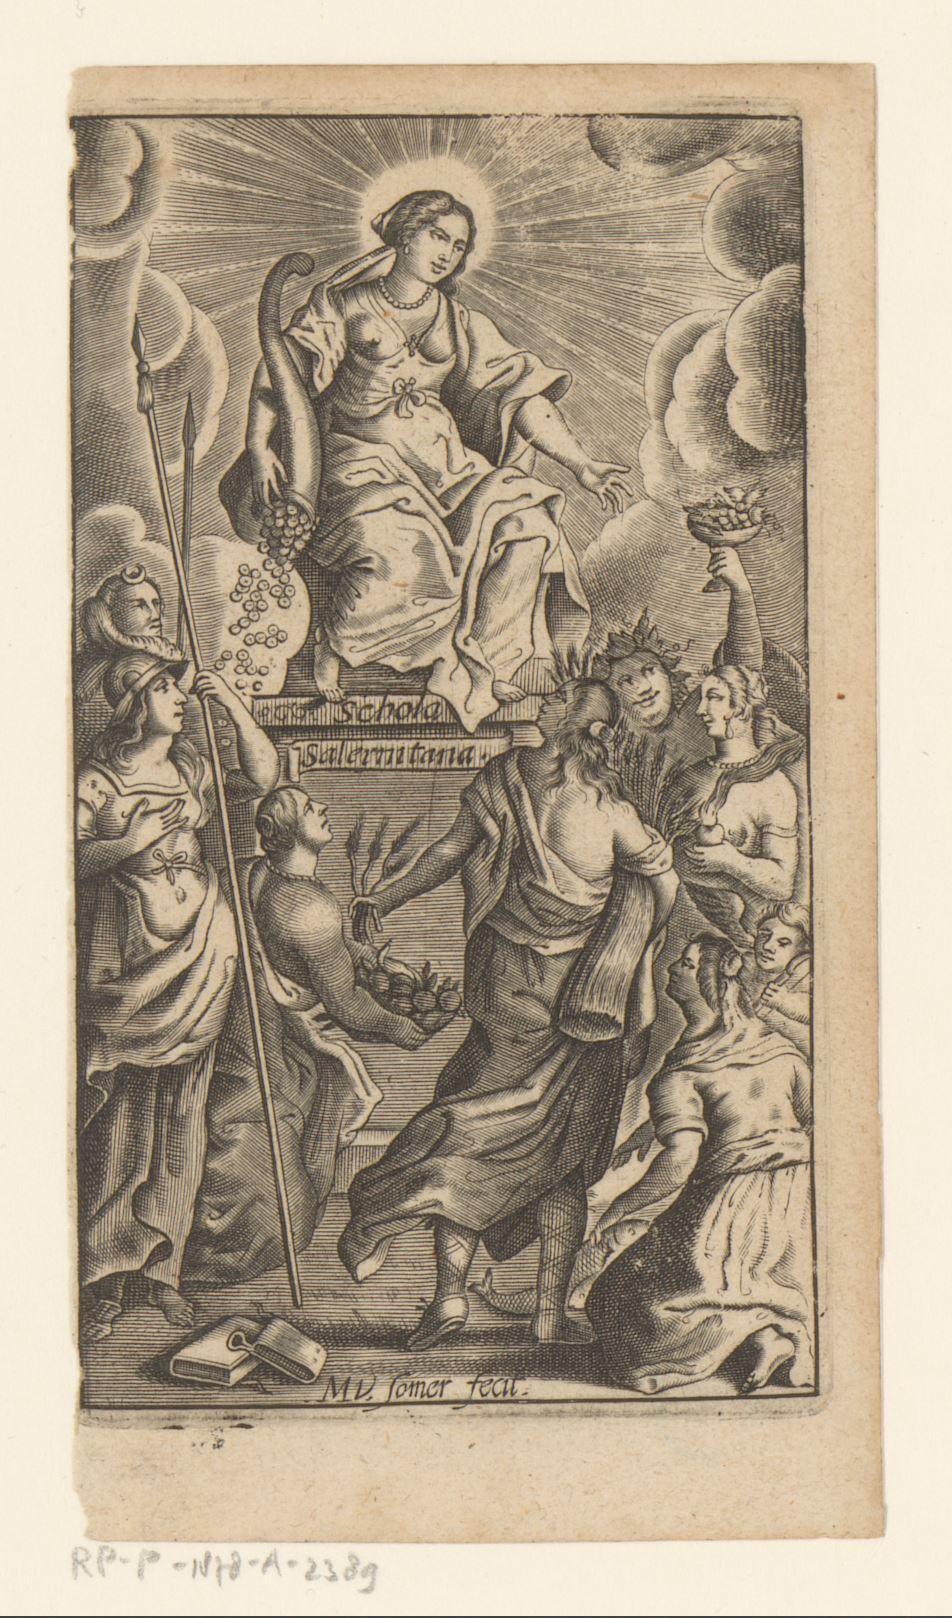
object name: titelblad, titelpagina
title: Personificatie van vrijgevigheid (Liberalitas)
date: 1649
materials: paper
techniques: engraving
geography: rotterdam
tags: 'cornucopia', horn of plenty, generosity, liberality; 'generosità', 'liberalità' (ripa)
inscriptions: inscription: ‘Schola salernitana sive De conservanda Valetudine autore Joanne de Mediolano Roterodami Ex officina A Leers MDCXLIV 1649 by Dr de Ridder het boekje’, collector's mark: Lugt 2228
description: Prent gebruikt voor de publicatie: Mediolano, Johannes de. Schola Salernitana. Rotterdam: Arnold Leers, 1649.